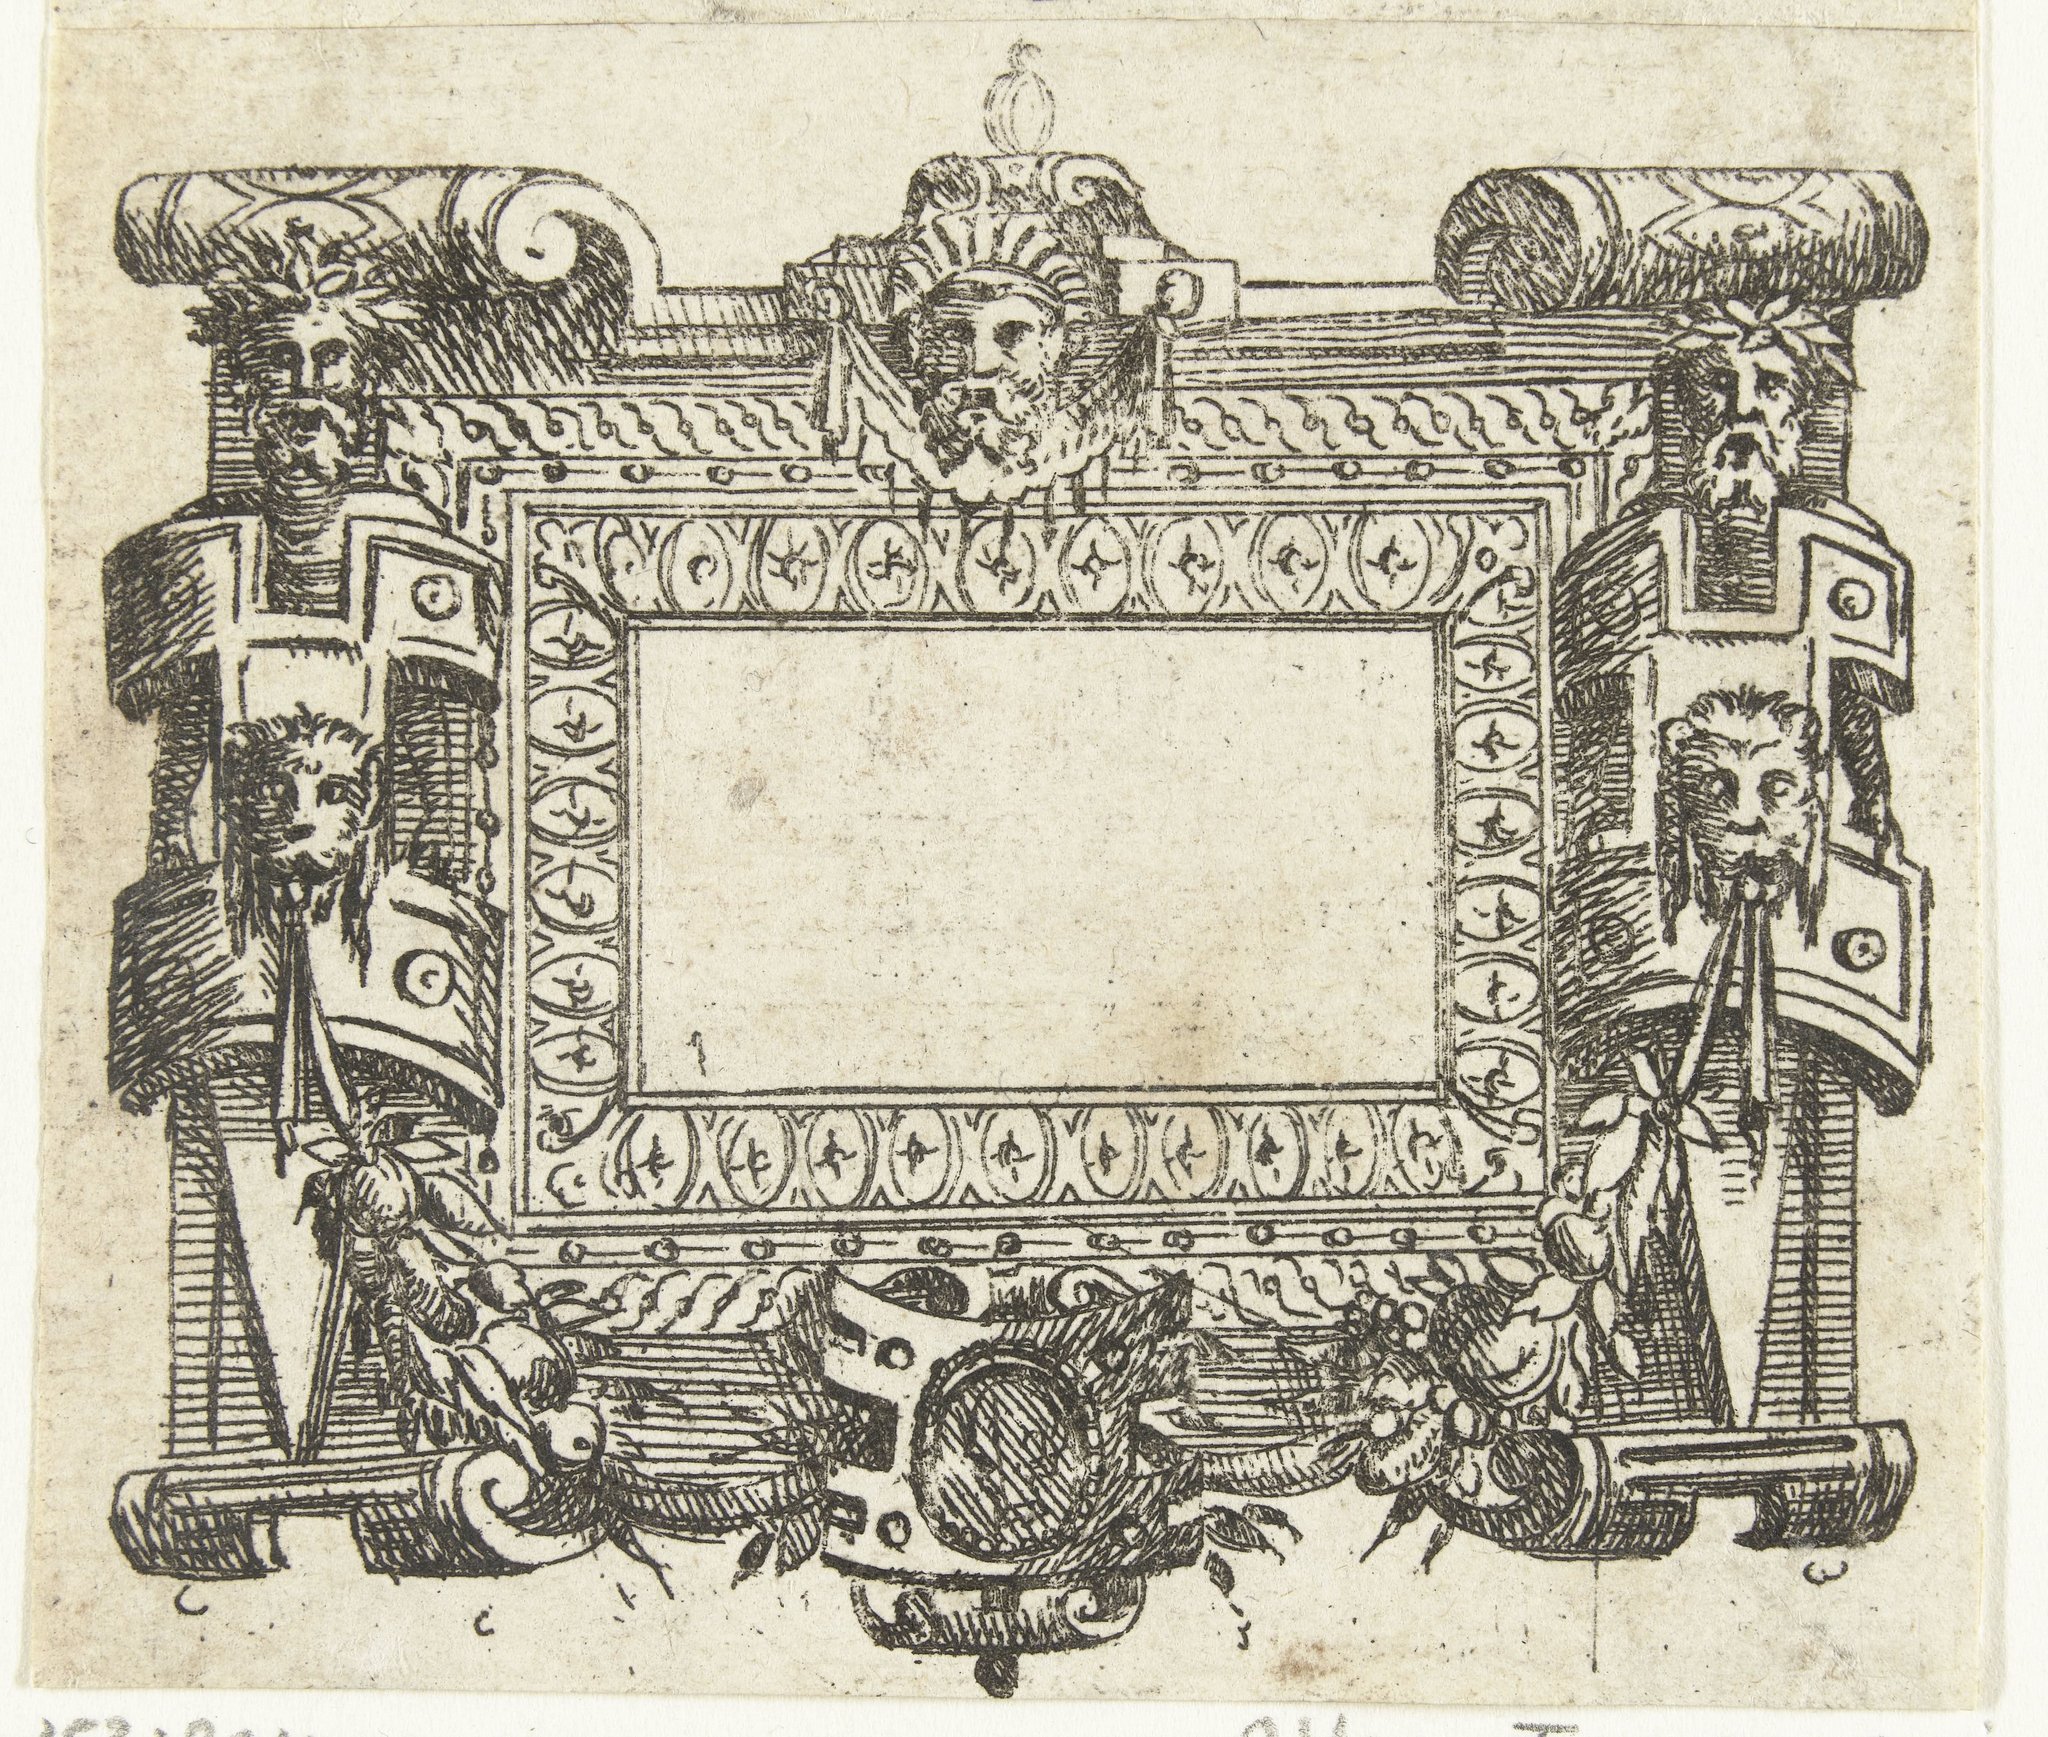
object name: print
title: Rechthoekige cartouche tussen twee hermen, gevat in rolwerk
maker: Anonymous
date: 1500-1600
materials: paper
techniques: etching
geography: france